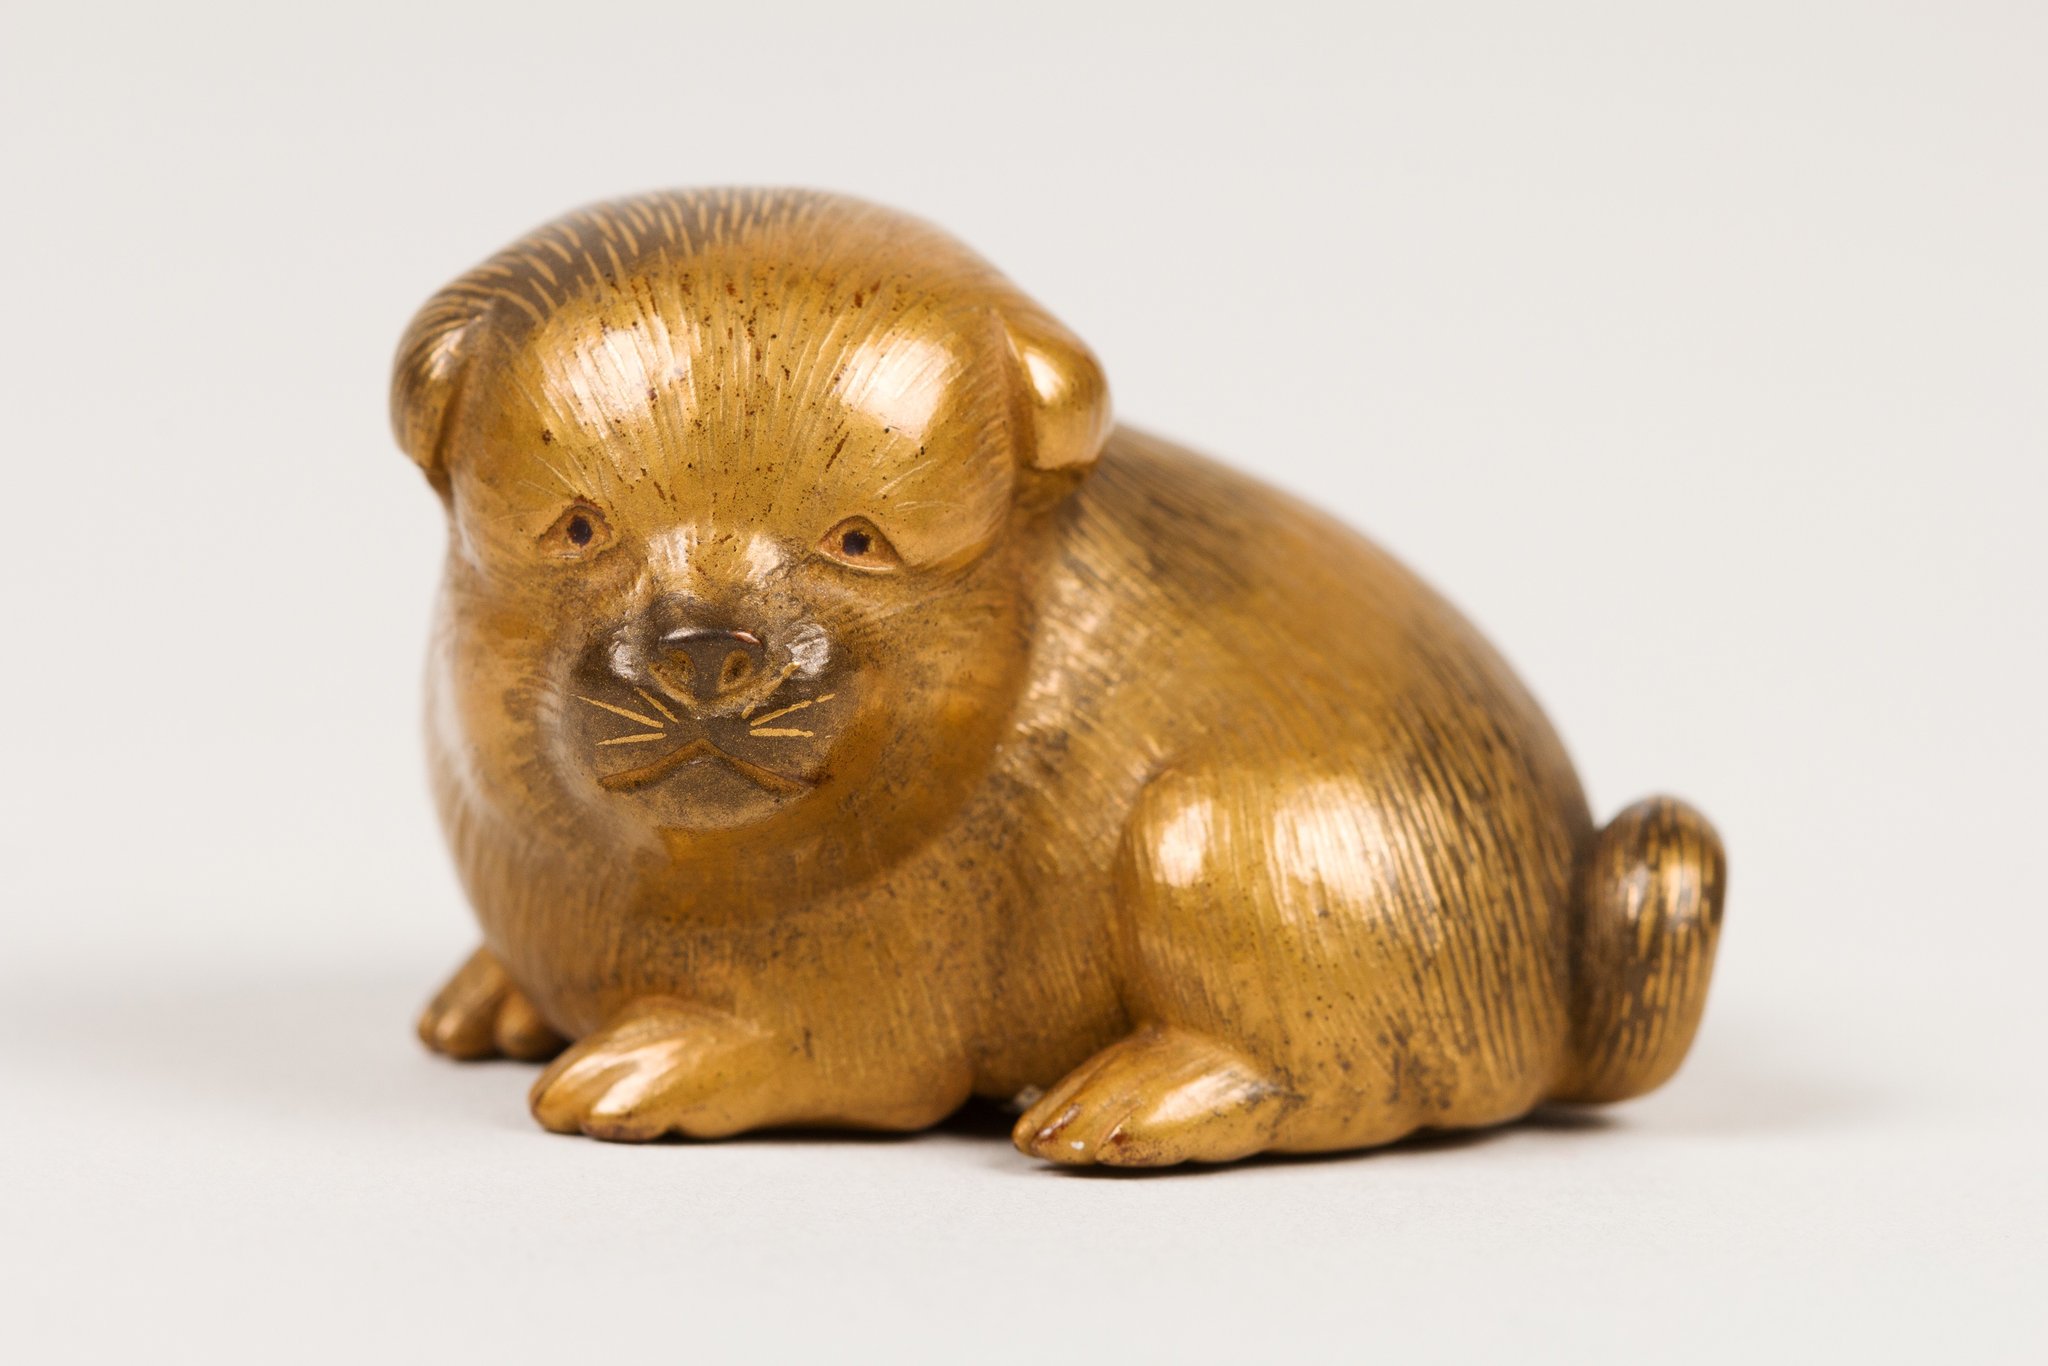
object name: netsuke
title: Netsuke of Seated Puppy with Short Curled Tail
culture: japanese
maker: norizane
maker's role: artist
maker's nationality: japanese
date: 1801-1850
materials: gold, lacquer, wood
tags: dogs